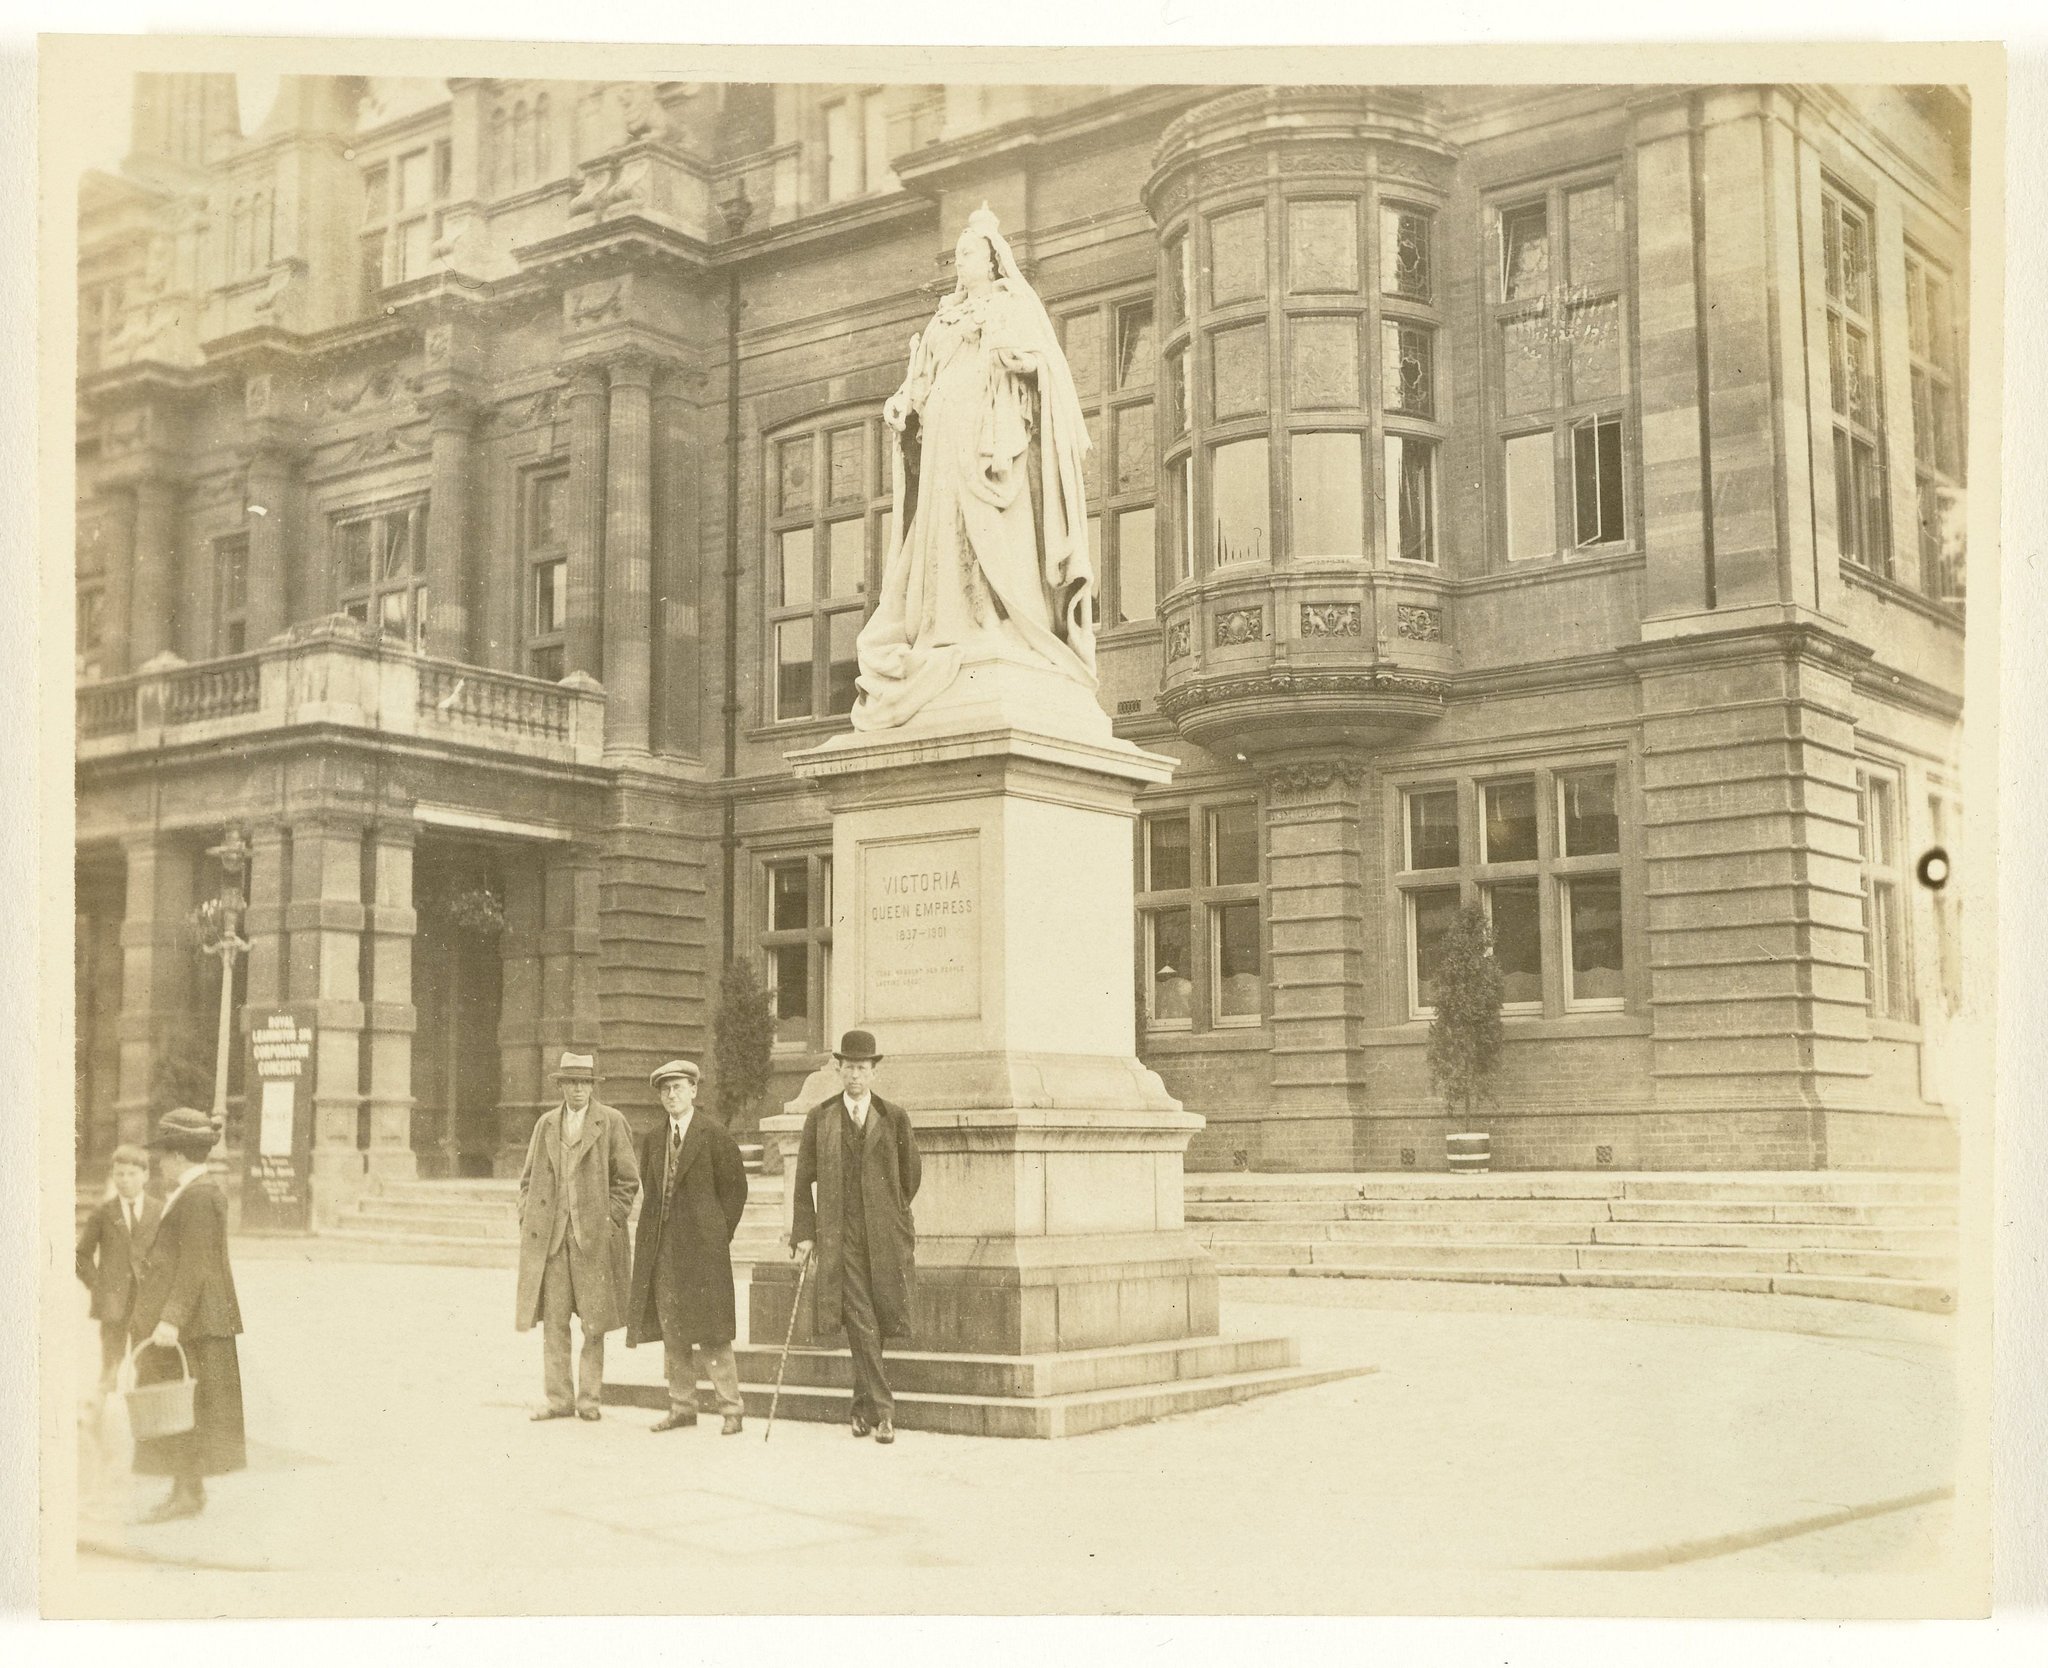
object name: photograph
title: Groep Amerikaanse toeristen bij het standbeeld van koningin Victoria voor de Town Hall in Leamington Spa, Engeland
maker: Anonymous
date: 1921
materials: paper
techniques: gelatin silver print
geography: north and central america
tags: tourism, monument, statue